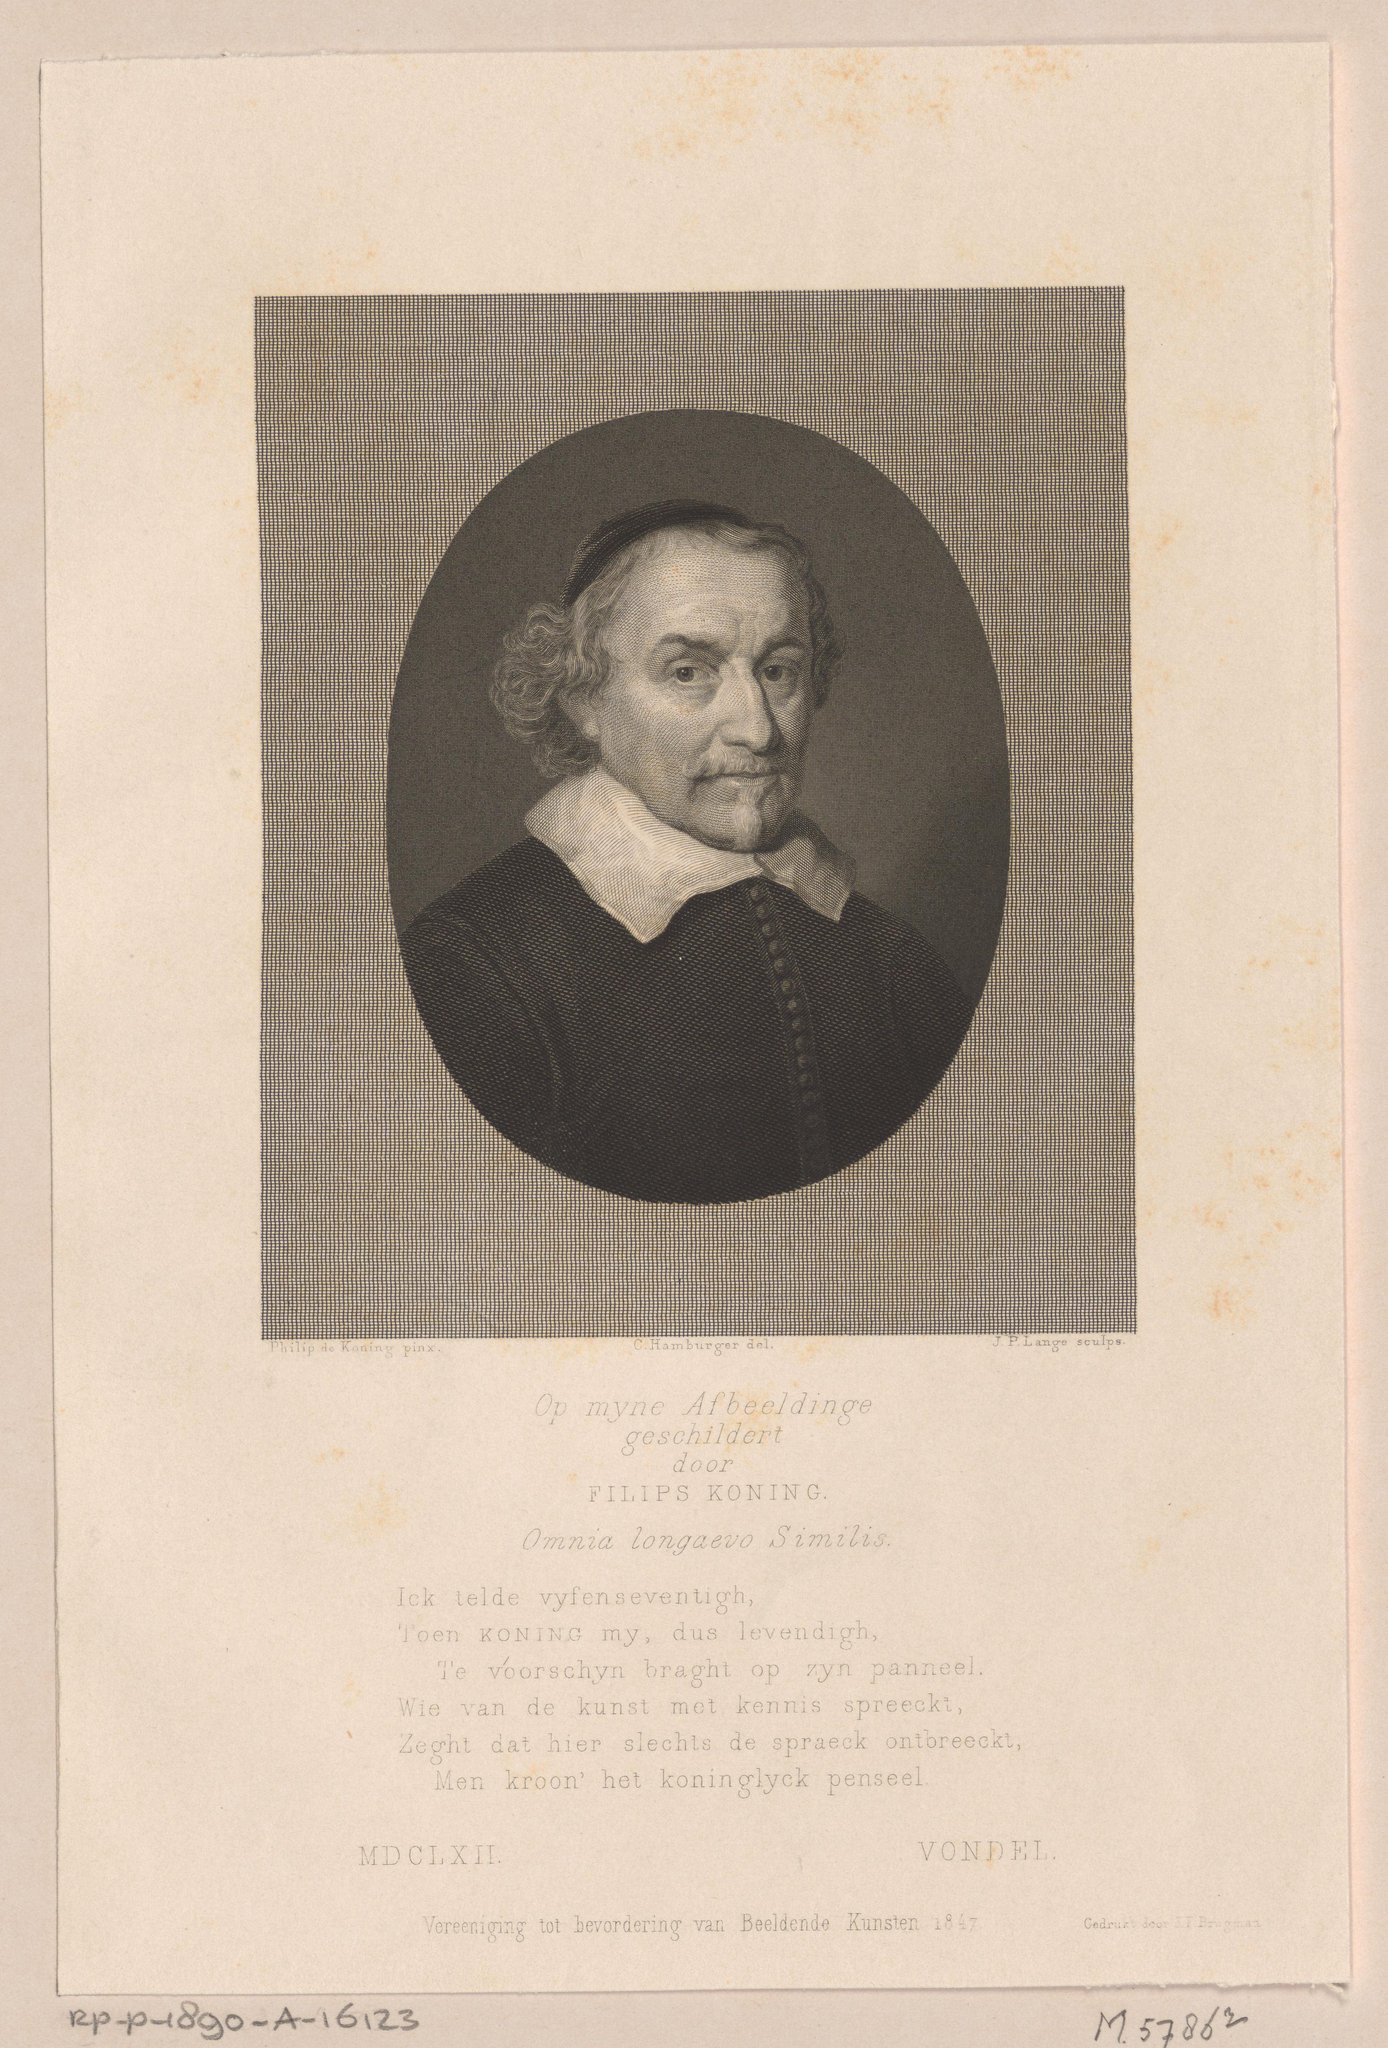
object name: print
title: Portret van Joost van den Vondel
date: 1847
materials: paper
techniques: engraving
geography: amsterdam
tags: cologne, amsterdam, joost van den vondel, historical persons, portrait of a writer, writer, poet, author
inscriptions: collector's mark: Lugt 2228